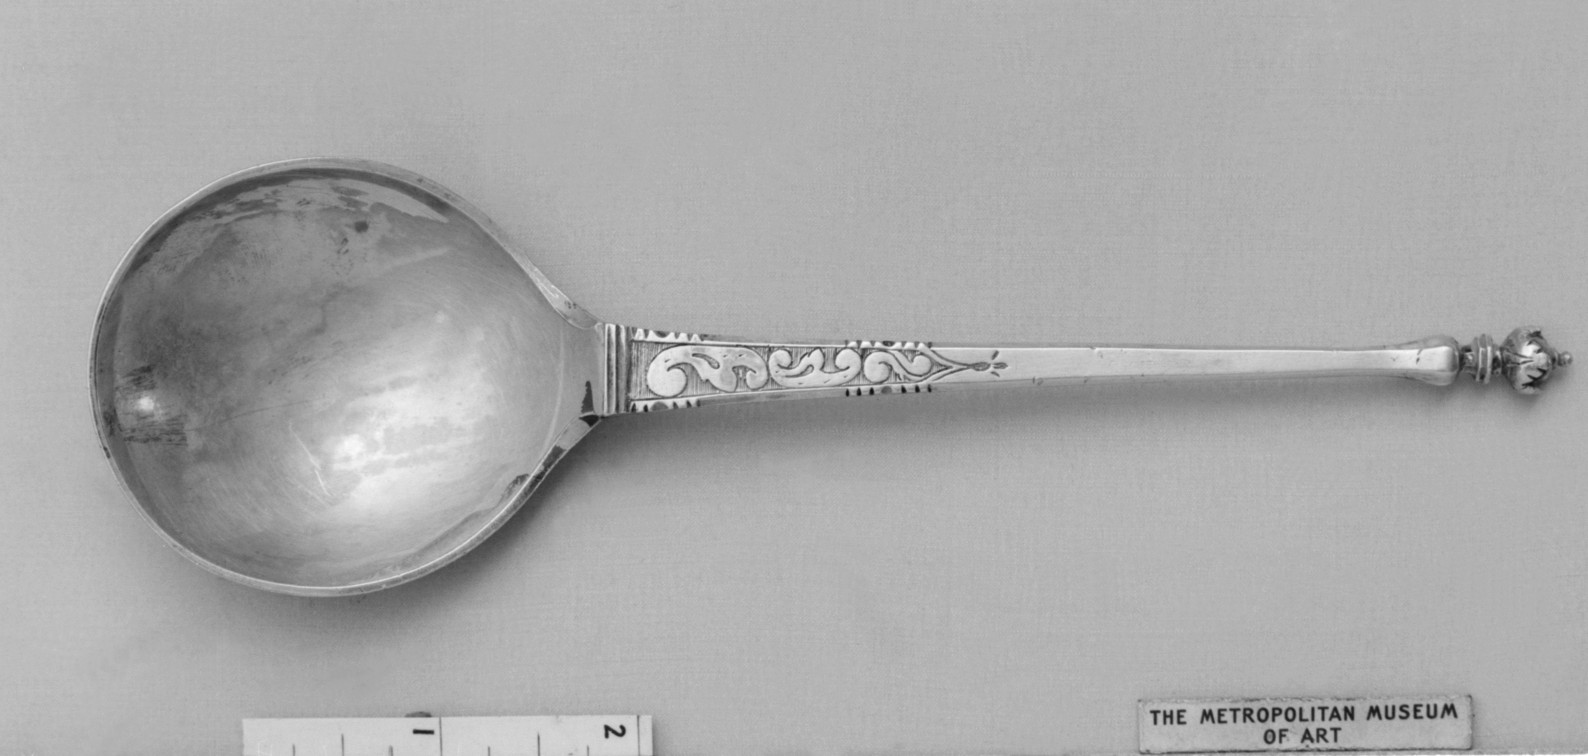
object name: spoon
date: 1628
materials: silver